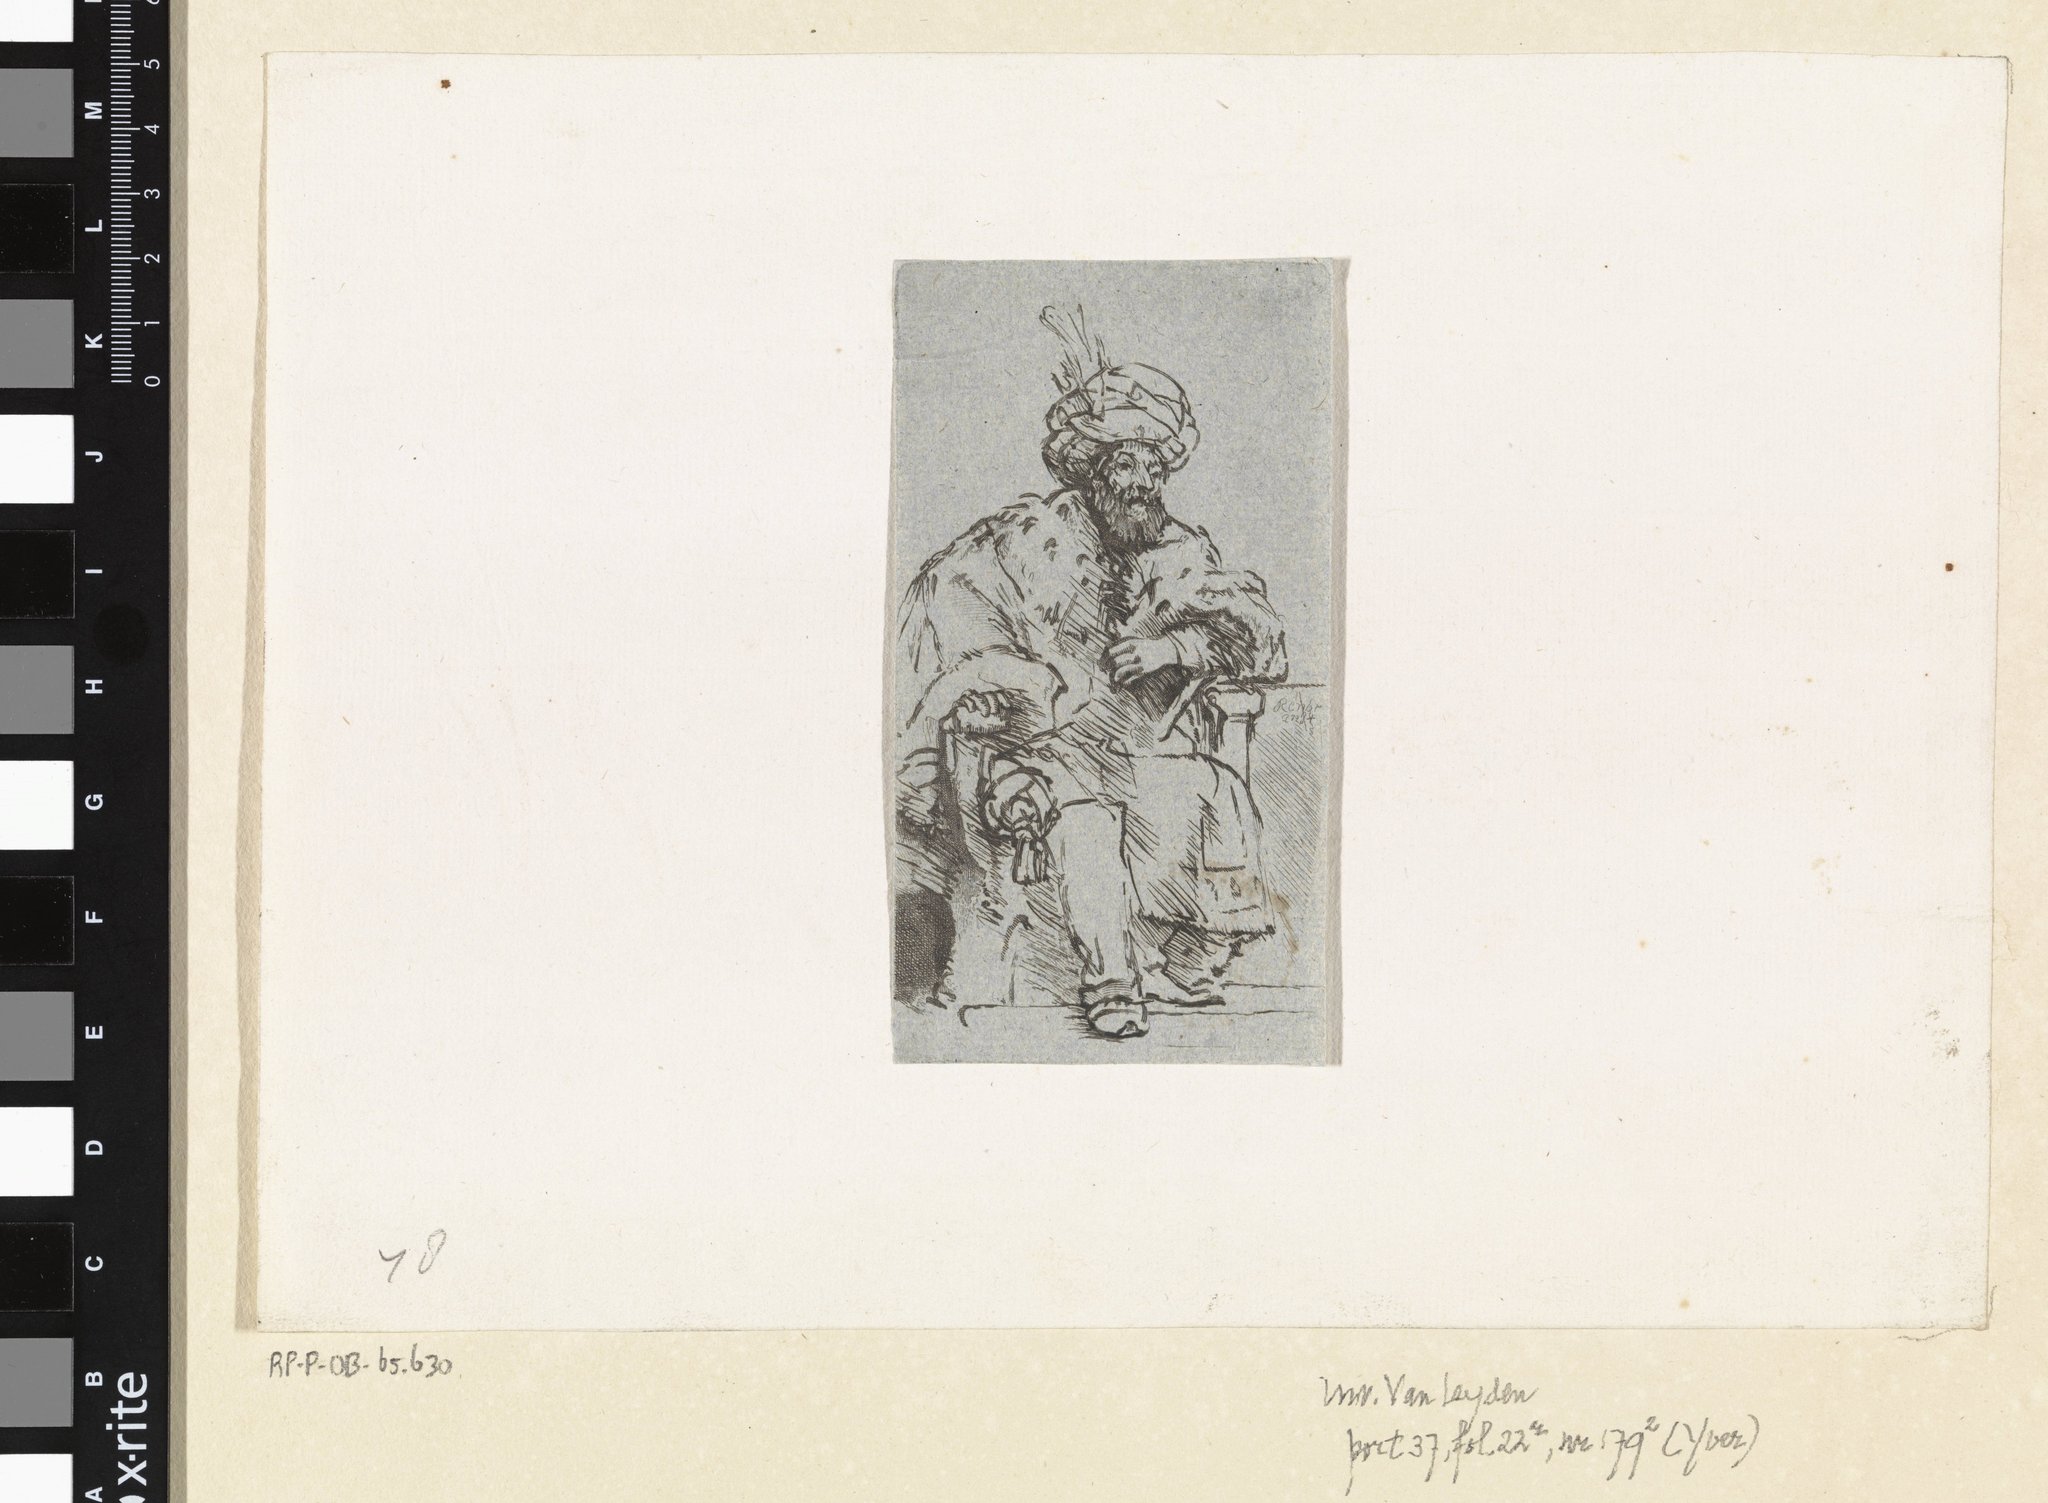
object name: print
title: Verscheide gedagten in het koper gebragt naar de origenelen teekeningen en schetschen van Rembrandt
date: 1696-1727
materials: paper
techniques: engraving, etching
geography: amsterdam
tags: david (not in biblical context); possible attributes: crown, harp, head-gear: turban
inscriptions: collector's mark: Lugt 240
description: Koning David zit op zijn troon. Hij draagt zijn koningsmantel en is getooid met een tulband.